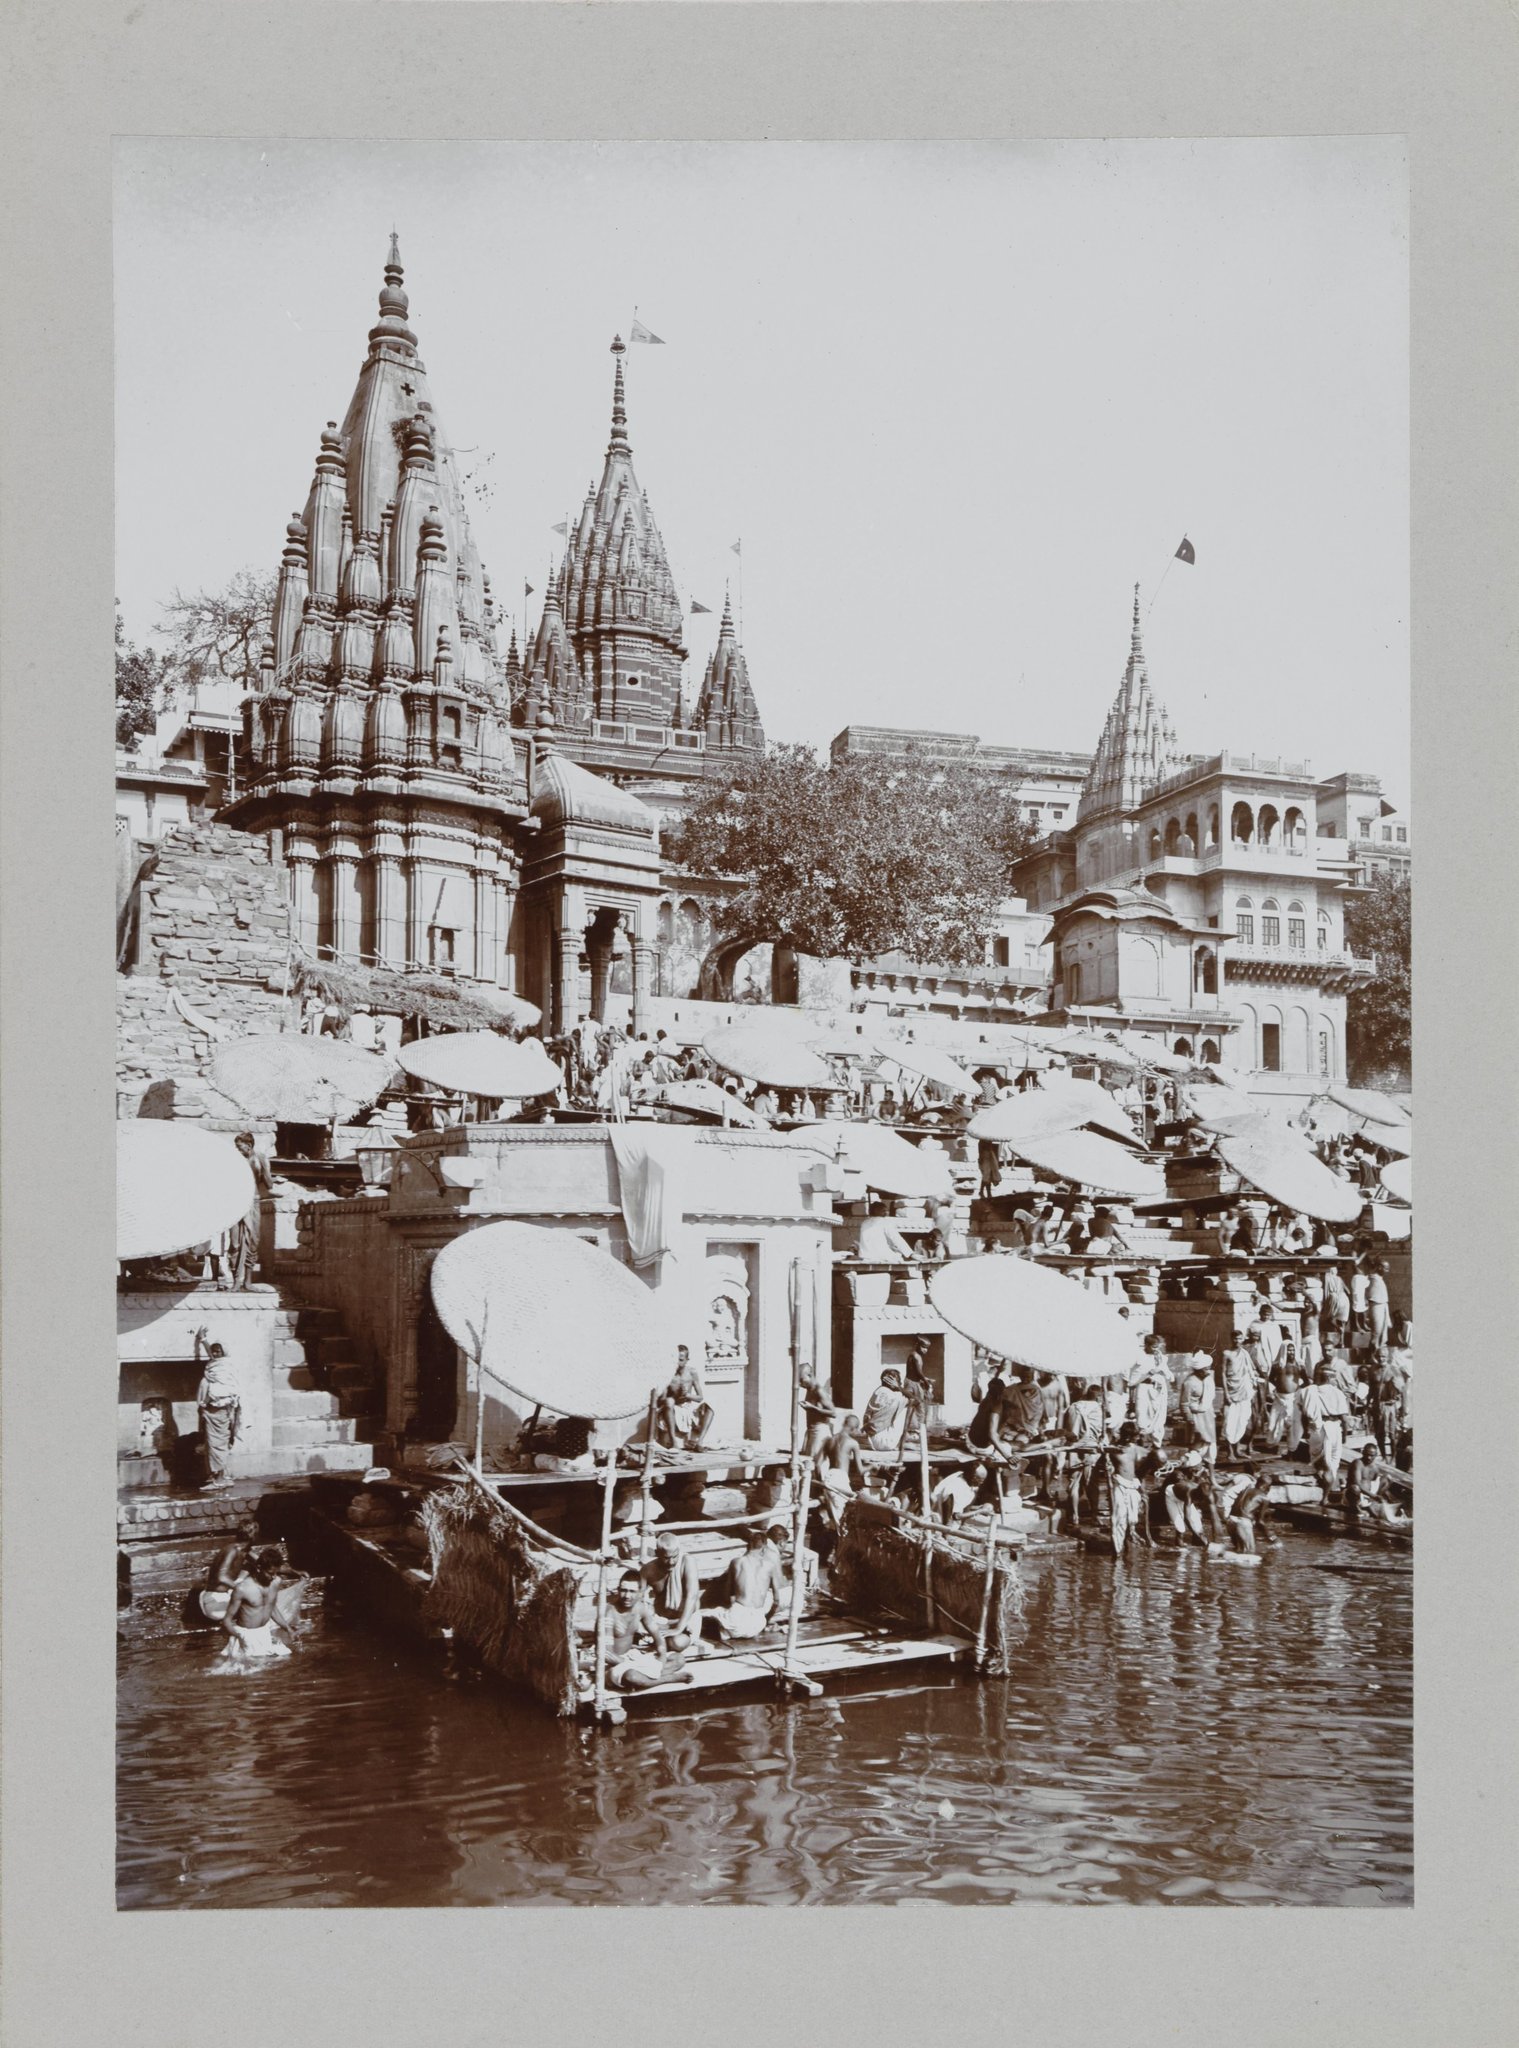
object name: photograph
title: People and temples by the Ganga river at Varanasi, Uttar Pradesh, India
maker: Anonymous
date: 1895-1915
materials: cardboard, paper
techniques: gelatin silver print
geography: varanasi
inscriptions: annotation: ‘8. Benares.’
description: Linksonder loopt een man door het water, boven hem houdt een vrouw haar hand tegen een muur.